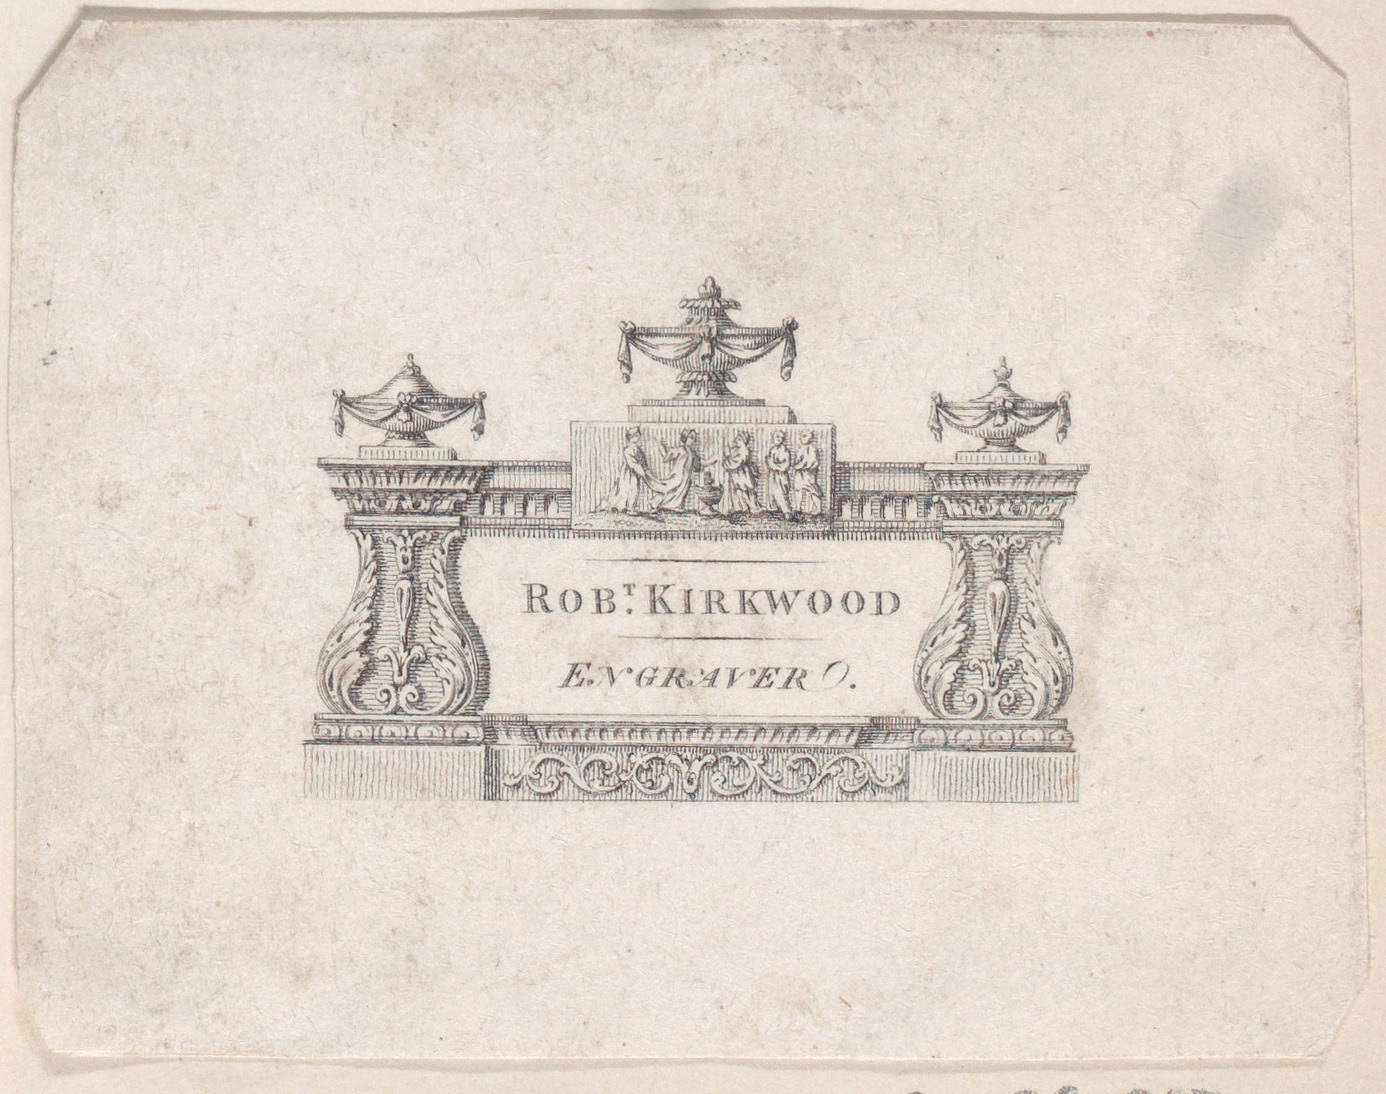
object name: print, trade card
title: Trade Card for Rob Kirkwood, Engraver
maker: anonymous, british, 19th century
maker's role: artist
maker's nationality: british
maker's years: 1800-1900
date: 1801-1900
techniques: engraving